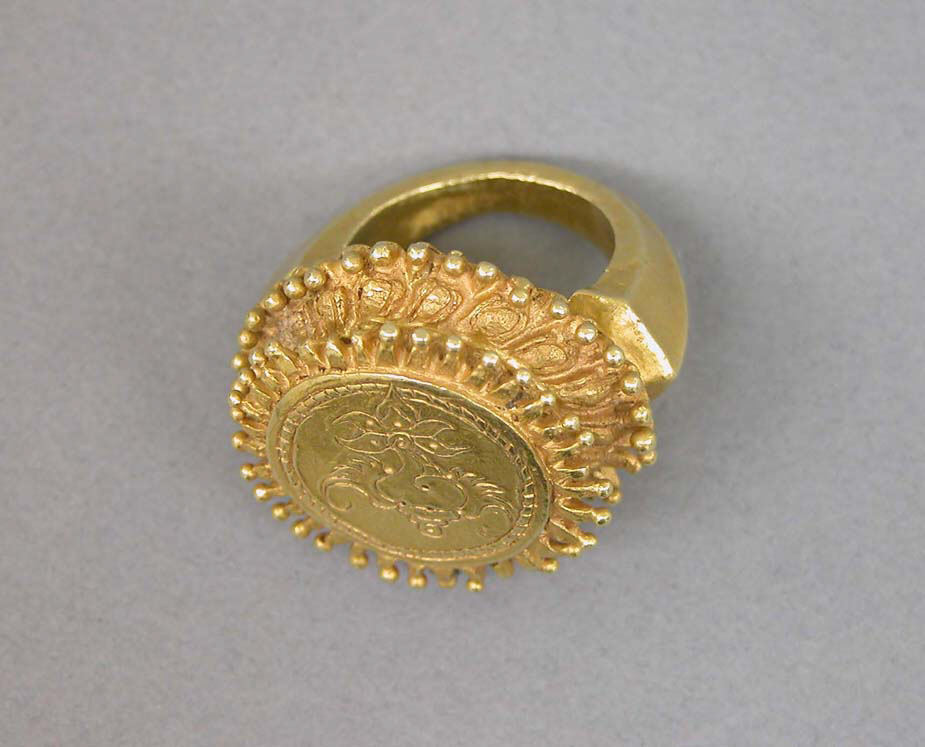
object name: ring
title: Stirrup-shaped Ring with Circular Bezel with Inscribed "Shankha"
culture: indonesian, javanese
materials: gold